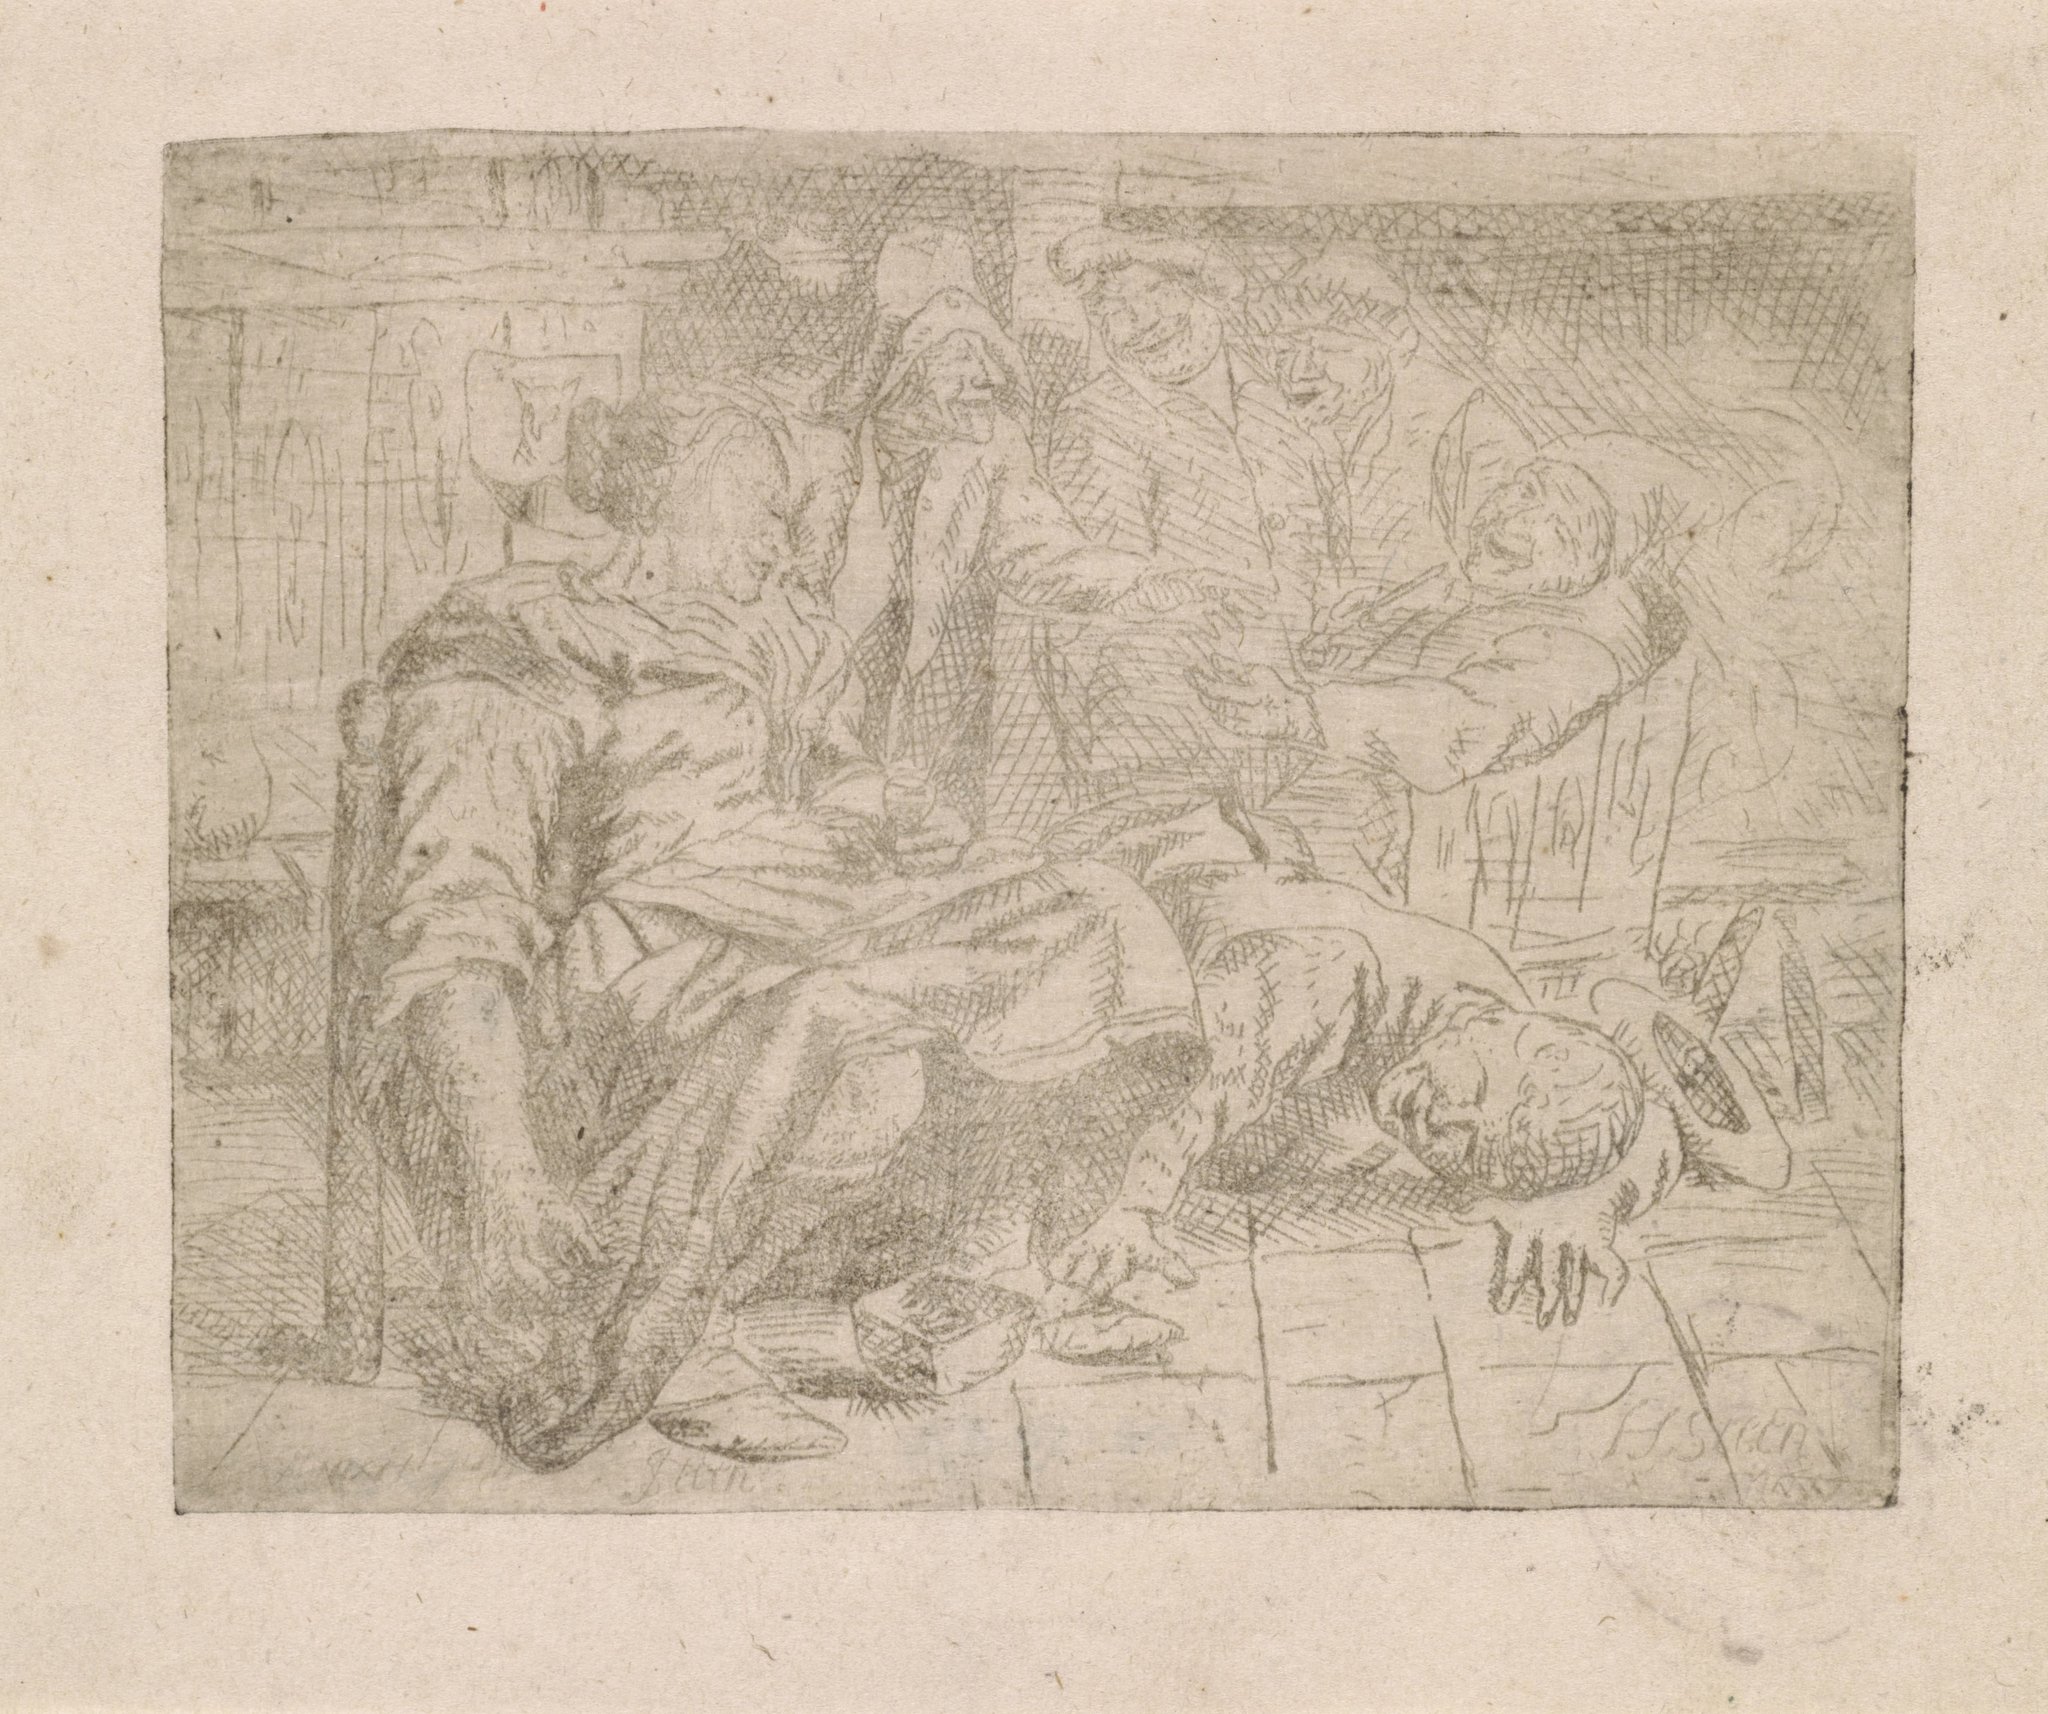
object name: print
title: Herberg met lachend gezelschap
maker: Anonymous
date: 1635-1729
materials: paper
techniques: etching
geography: netherlands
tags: inn, coffee-house, public house, etc., laughing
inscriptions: collector's mark: Lugt 240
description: In een herberg zitten vier mannen en een vrouw te lachen. Een vijfde man ligt op de grond en grijpt naar de voet van de vrouw.